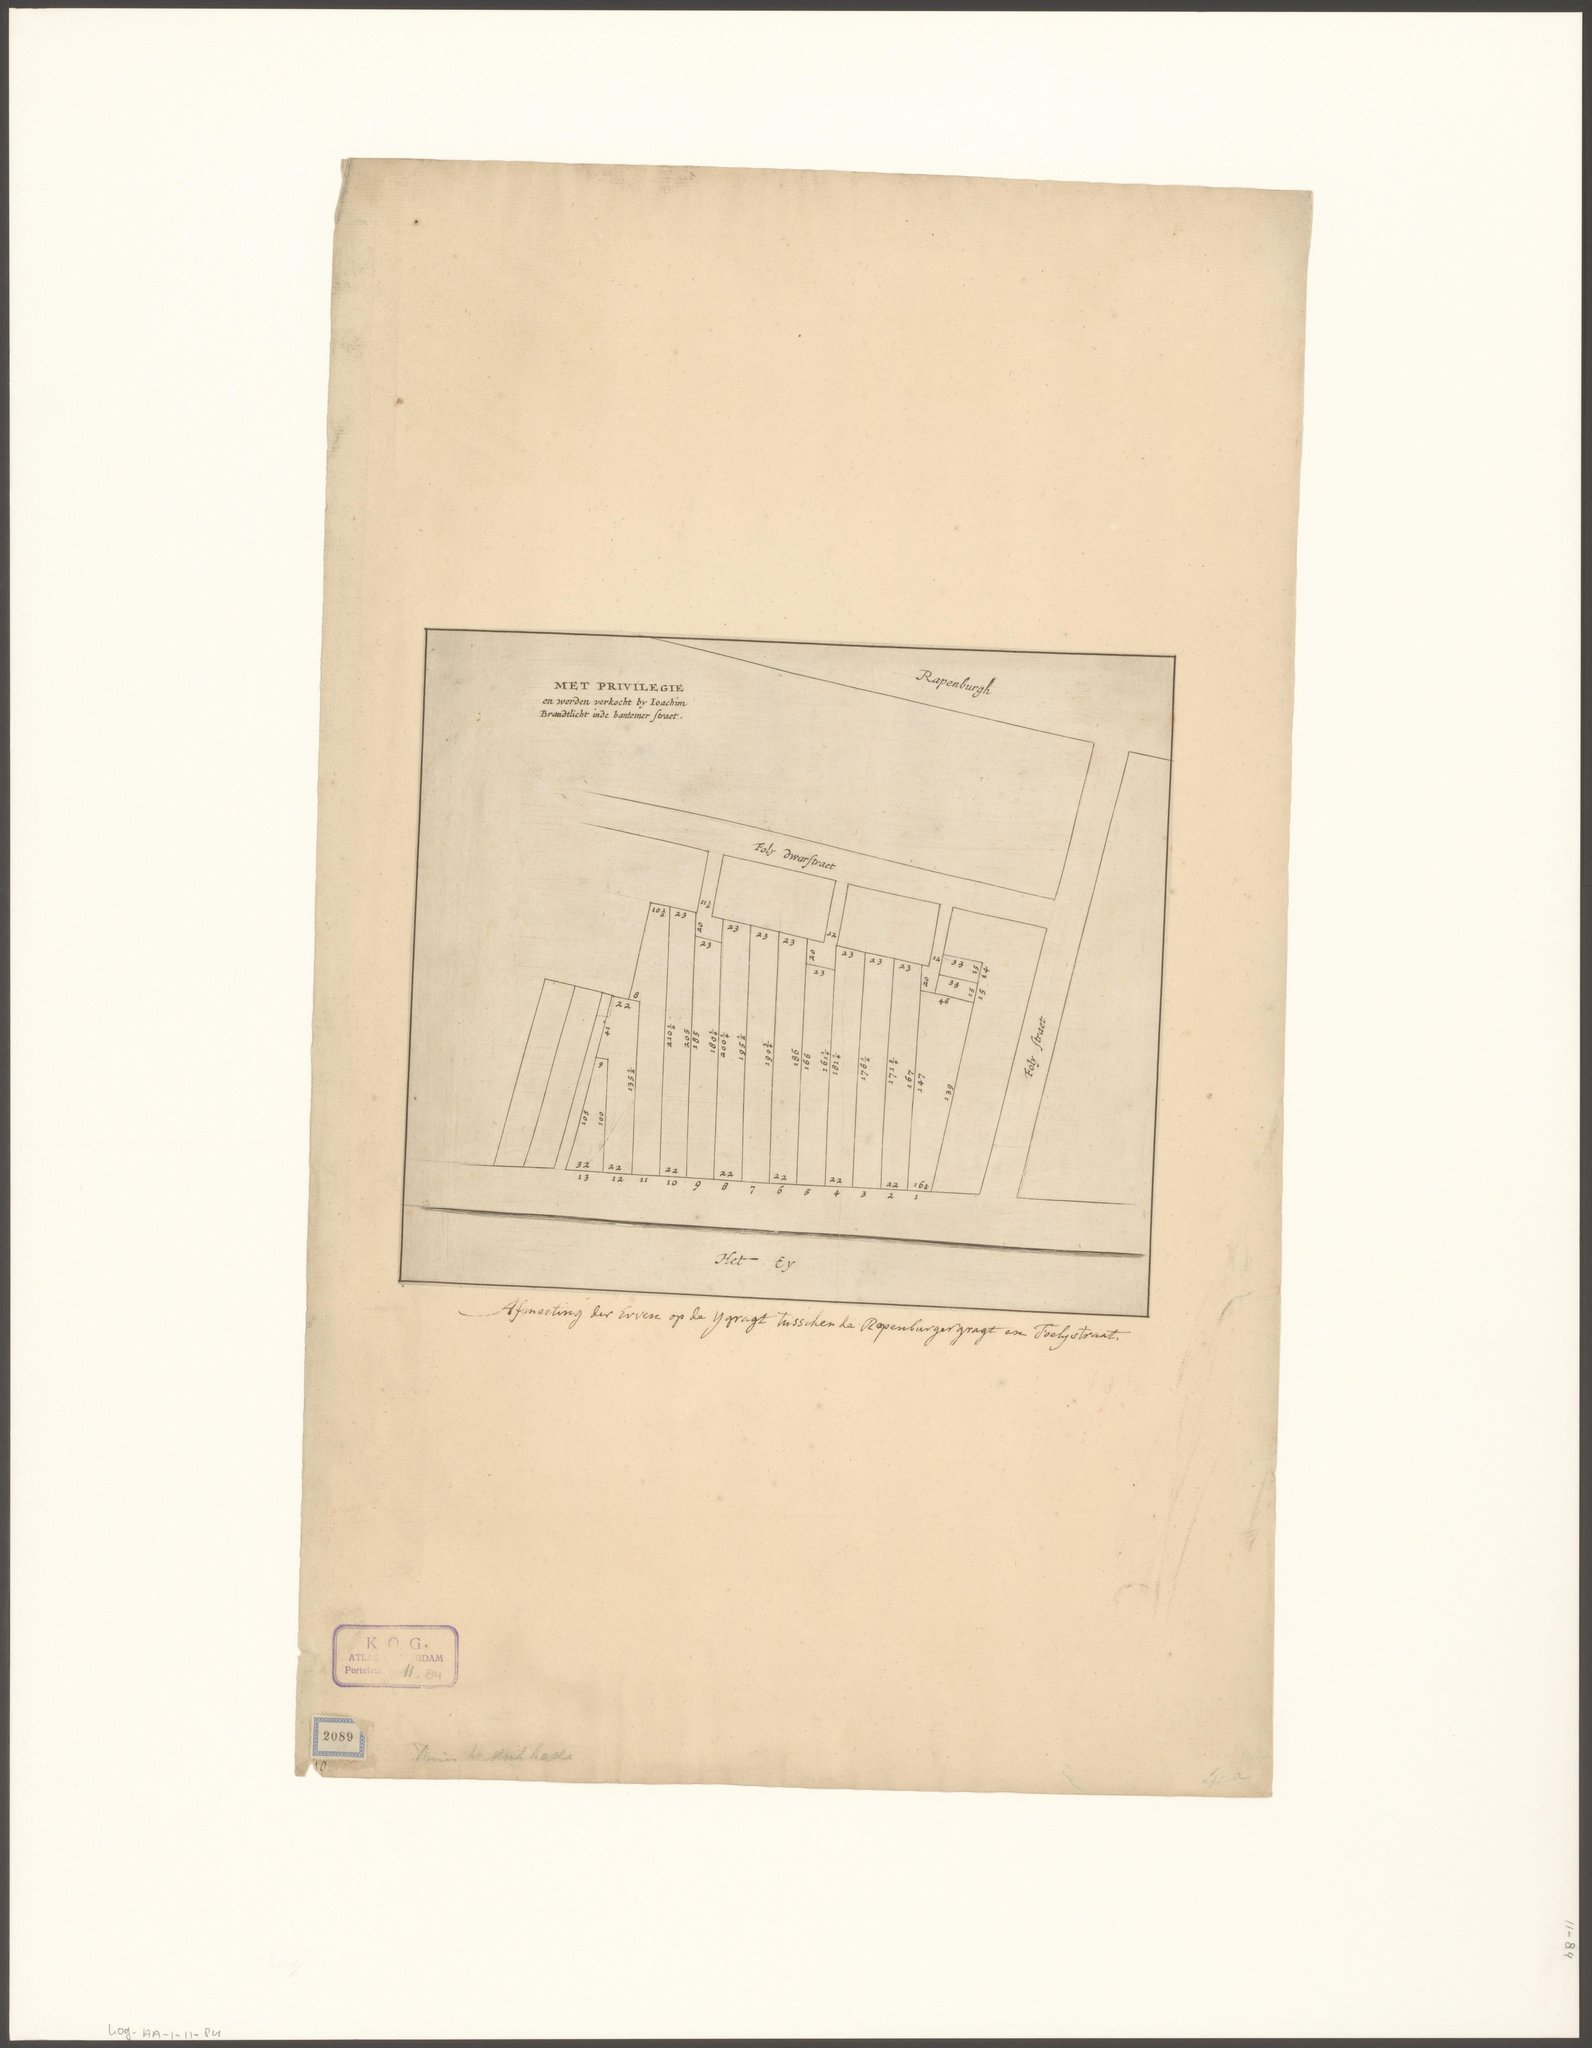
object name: print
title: Plattegrond van de percelen aan de IJgracht tussen de Rapenburgergracht en de Foeliestraat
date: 1650-1750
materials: paper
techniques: engraving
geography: amsterdam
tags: plan ~ architecture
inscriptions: collector's mark: ‘11.84’ Lugt 1641b, inscription: ‘Afmeeting der Erven op de Ygragt tusschen de Rapenburgergragt en Foelystraat.’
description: Onderwerpsrubriek binnen de Atlas Amsterdam: Prinsengracht, Korte Prinsengracht, Prins Hendrikkade. Zie ook Portefeuille 1: gezichten van het IJ op de stad.